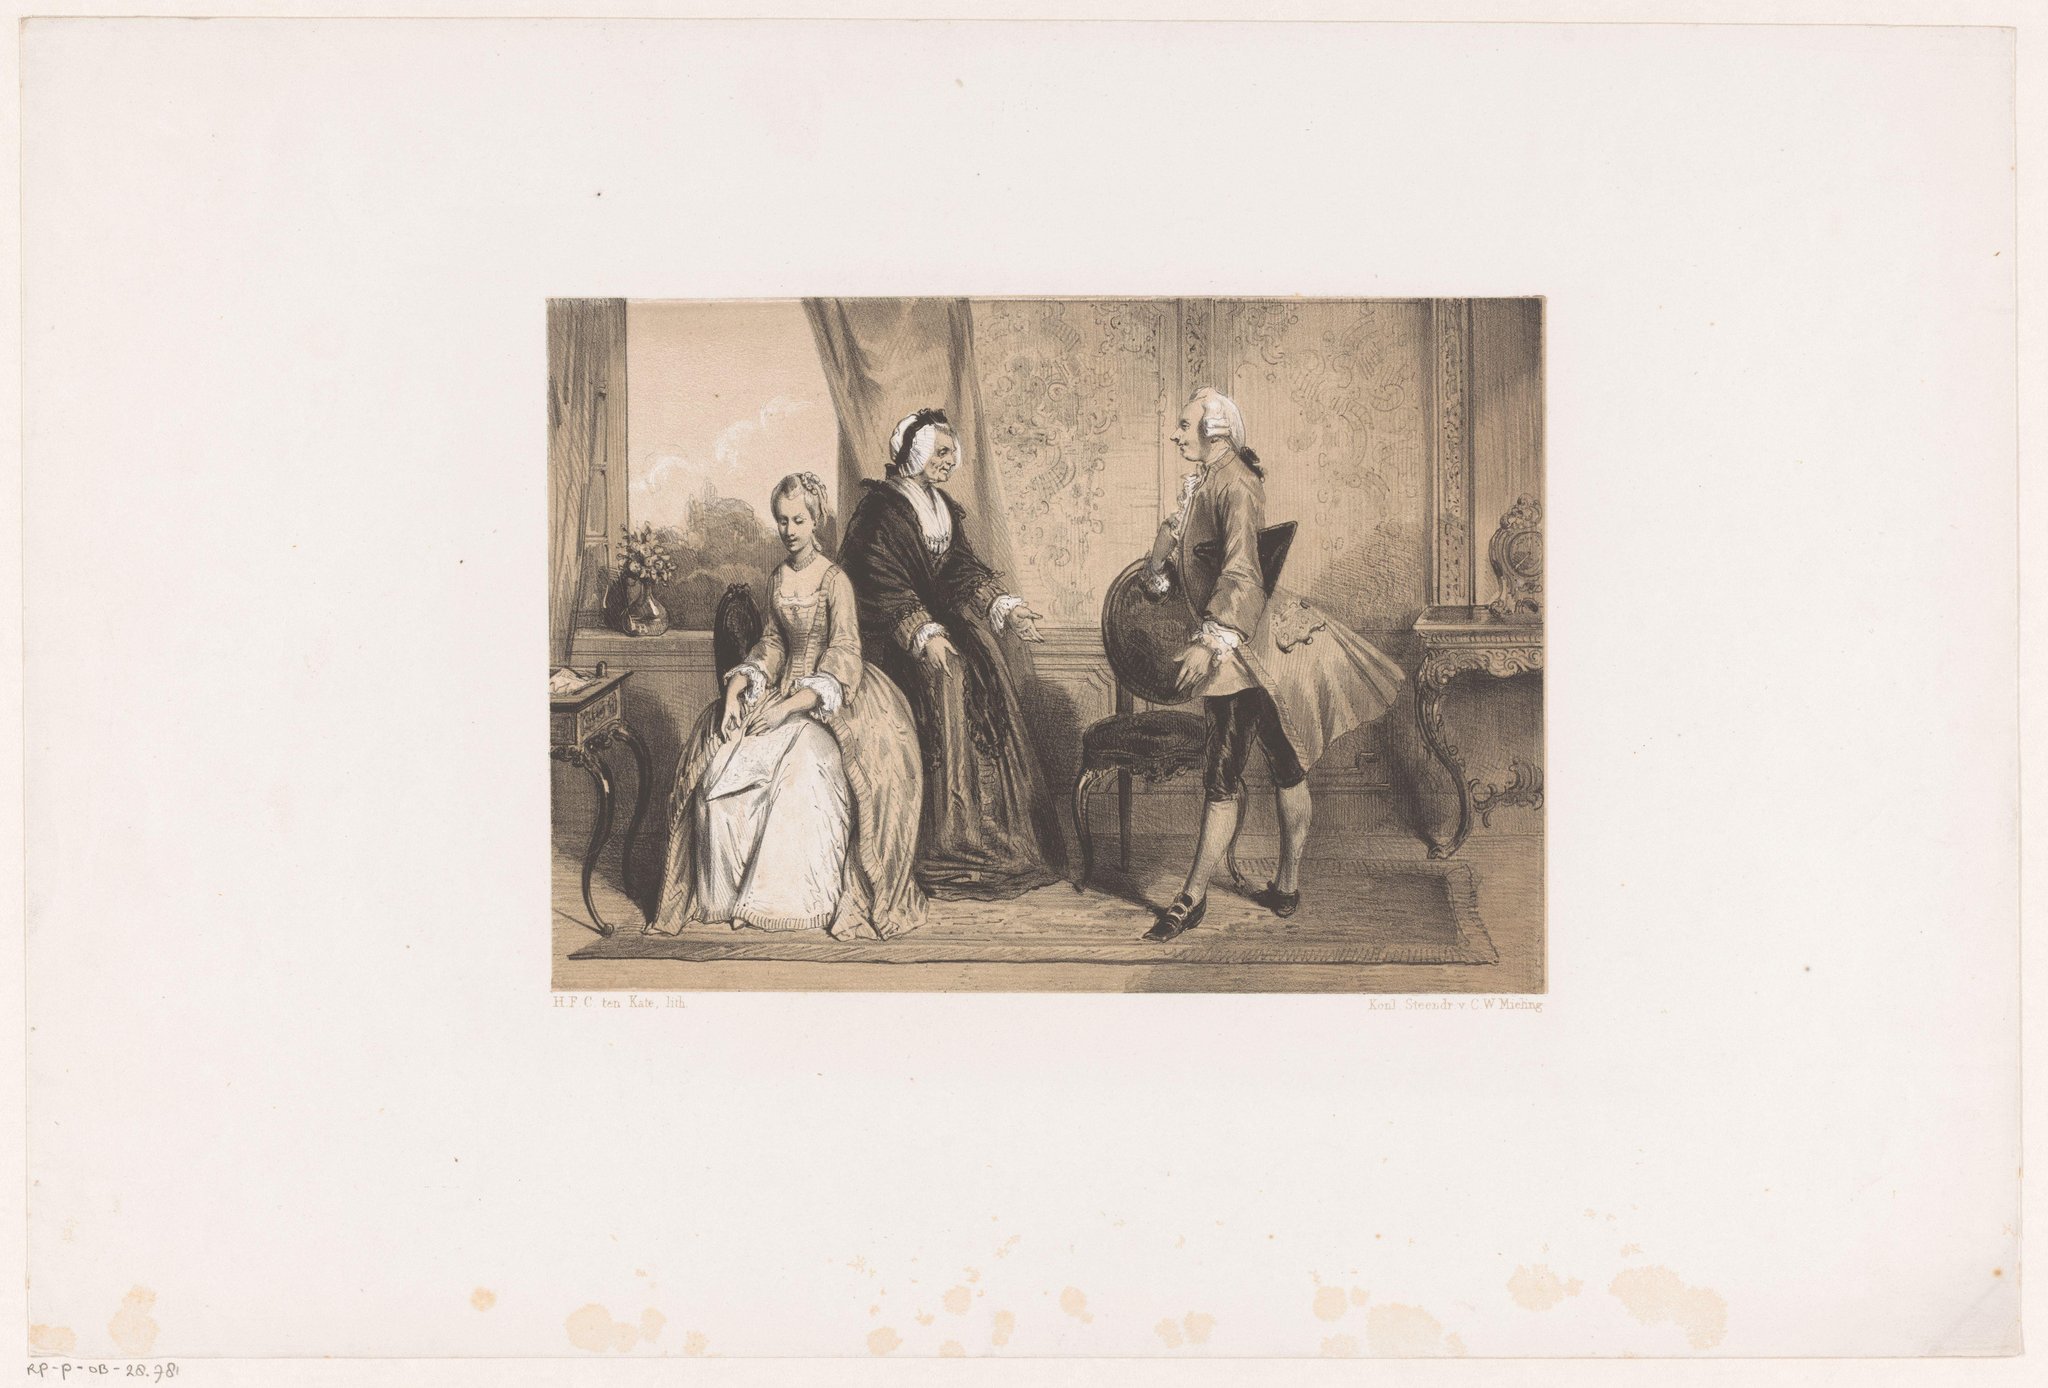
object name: print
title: Drie figuren in een 18de-eeuws interieur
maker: herman frederik carel ten kate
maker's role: draughtsman, painter, print maker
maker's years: 1822-1891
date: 1847-1863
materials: paper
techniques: tone lithography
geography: the hague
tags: courting, meeting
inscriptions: collector's mark: Lugt 2228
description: De man heeft zijn hoed afgenomen en stapt op de dame en oude vrouw af. De dame zit weggedraaid op een stoel. De oude vrouw begroet de man.